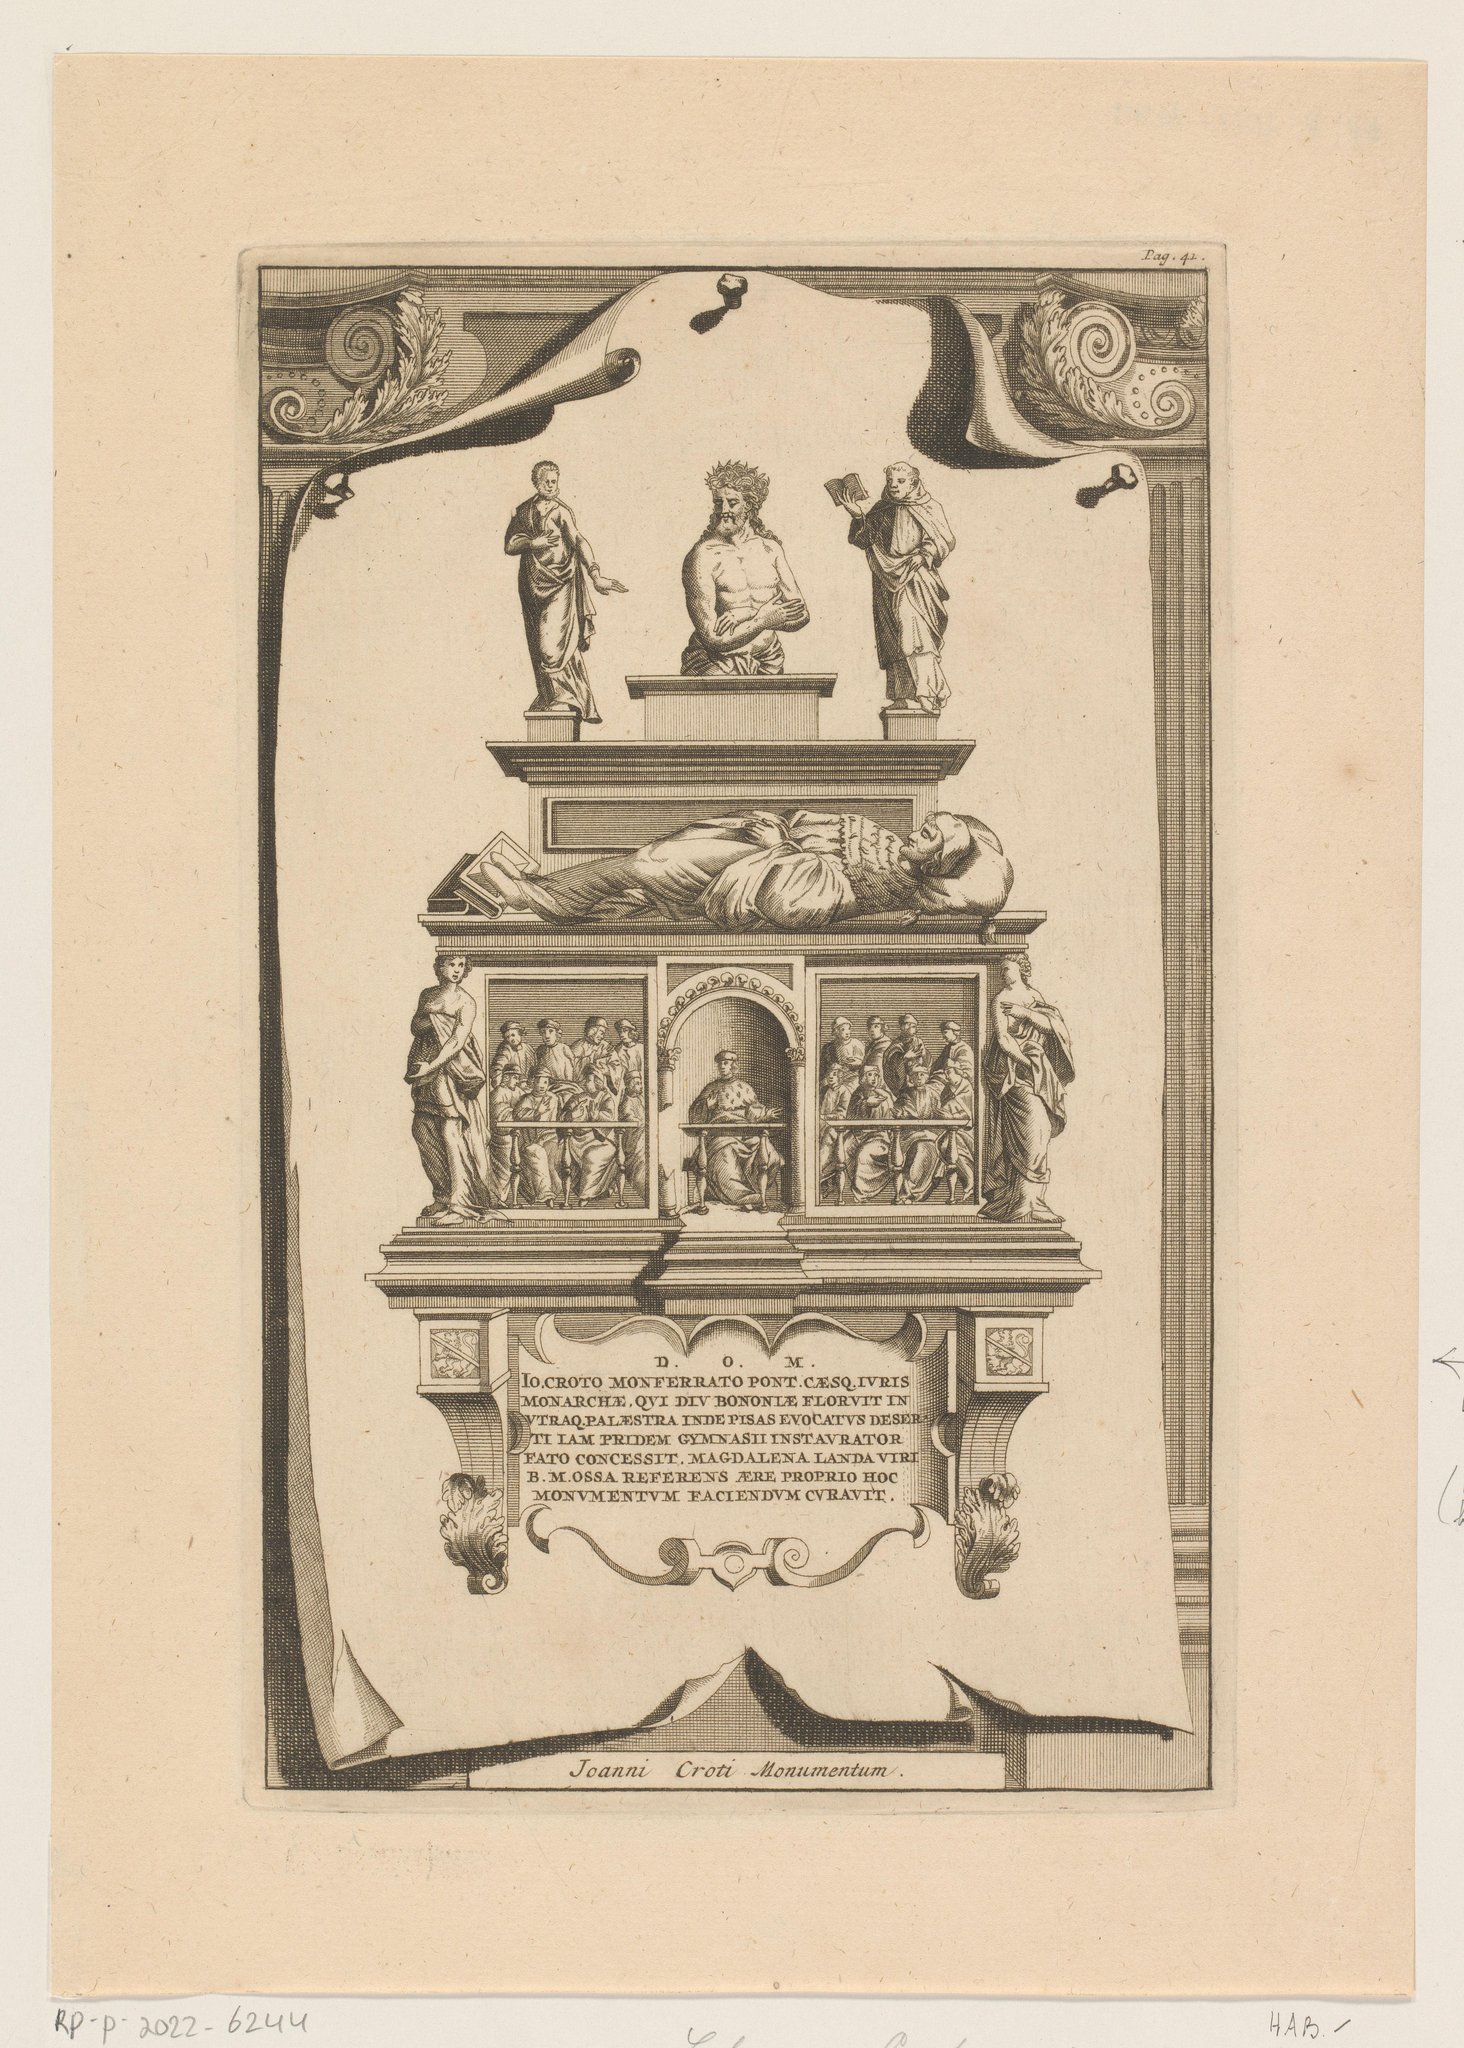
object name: print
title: Grafmonument voor Johann Crotus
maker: Anonymous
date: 1722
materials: paper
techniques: etching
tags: historical persons, grave-building, monumental tomb, theologian in his study (writing or reading)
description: Prent waarschijnlijk uit: Graevius, Johannes Georgius, Burmannus senior, Petrus. Thesaurus antiquitatum et historiarum Italiae (...). Leiden: Pieter van der Aa, 1722.